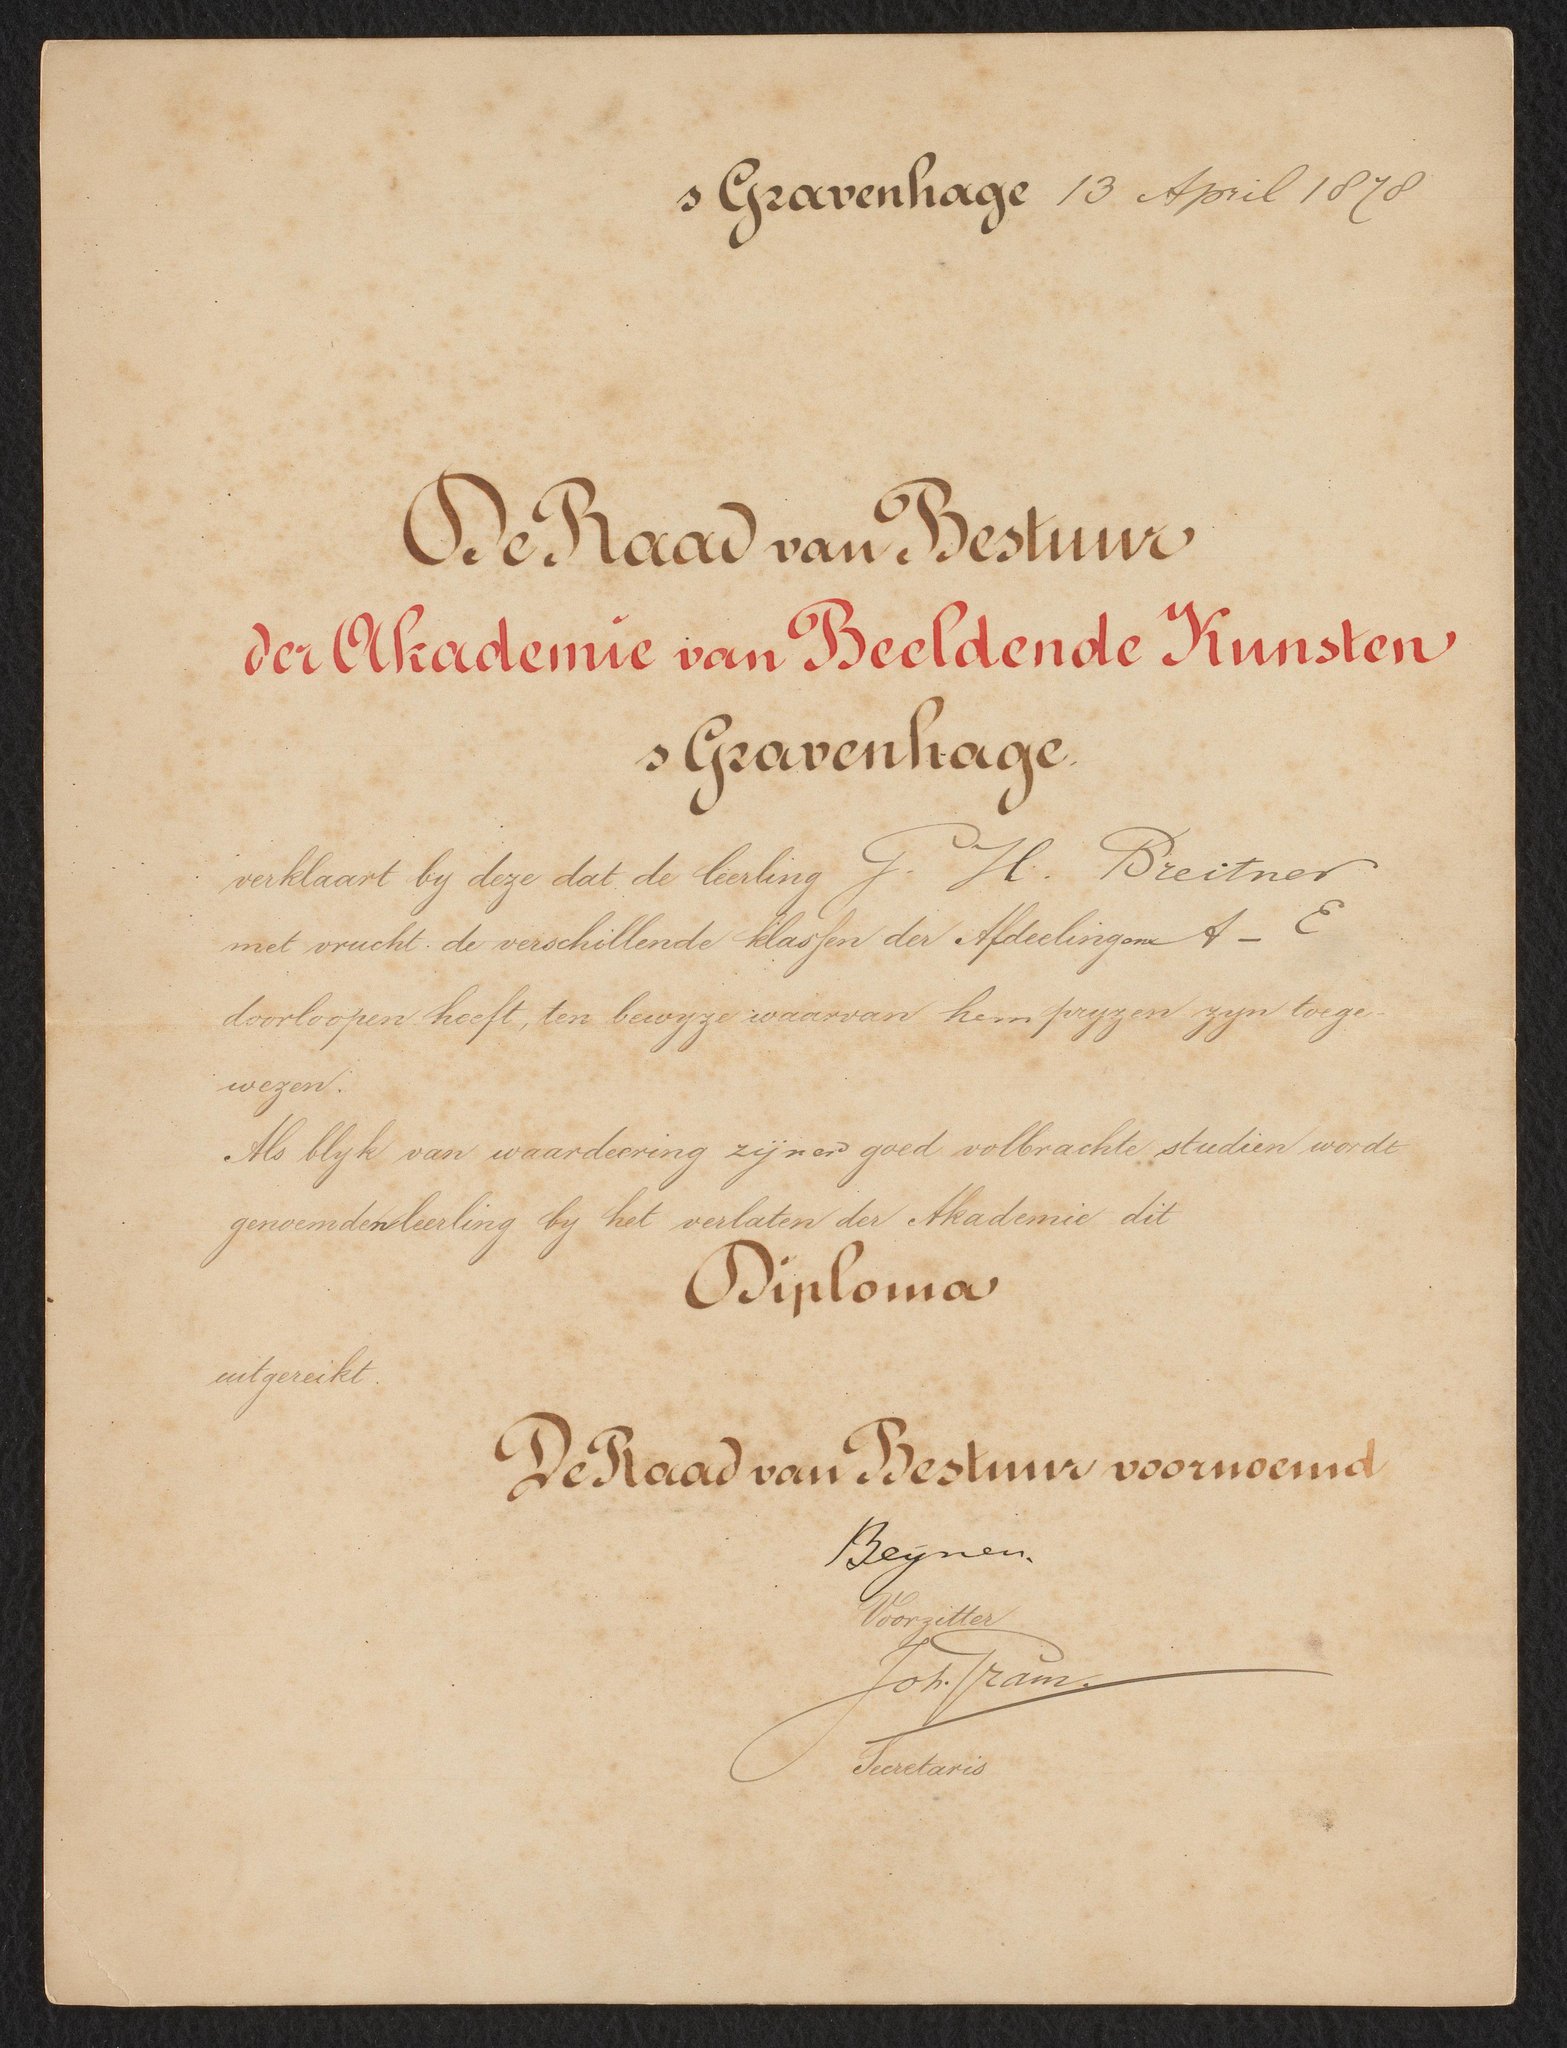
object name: certificate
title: Diploma van de Akademie van Beeldende Kunsten Den Haag uitgereikt aan George Hendrik Breitner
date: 1878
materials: ink, paper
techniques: pen in brown, pen in colors, pen in black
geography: the hague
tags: distribution of awards ~ art contest, the hague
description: Diploma uitgereikt aan George Hendrik Breitner voor het succesvol doorlopen van de verschillende klassen van de afdelingen A t/m E van de Akademie van Beeldende Kunsten 's Gravenhage. Het diploma is uitgereikt in Den Haag op 13 april 1878. Ondertekend door de voorzitter van de Raad van Bestuur, Laurens Reijnhard Beijnen, en de secretaris, Johan Gram.